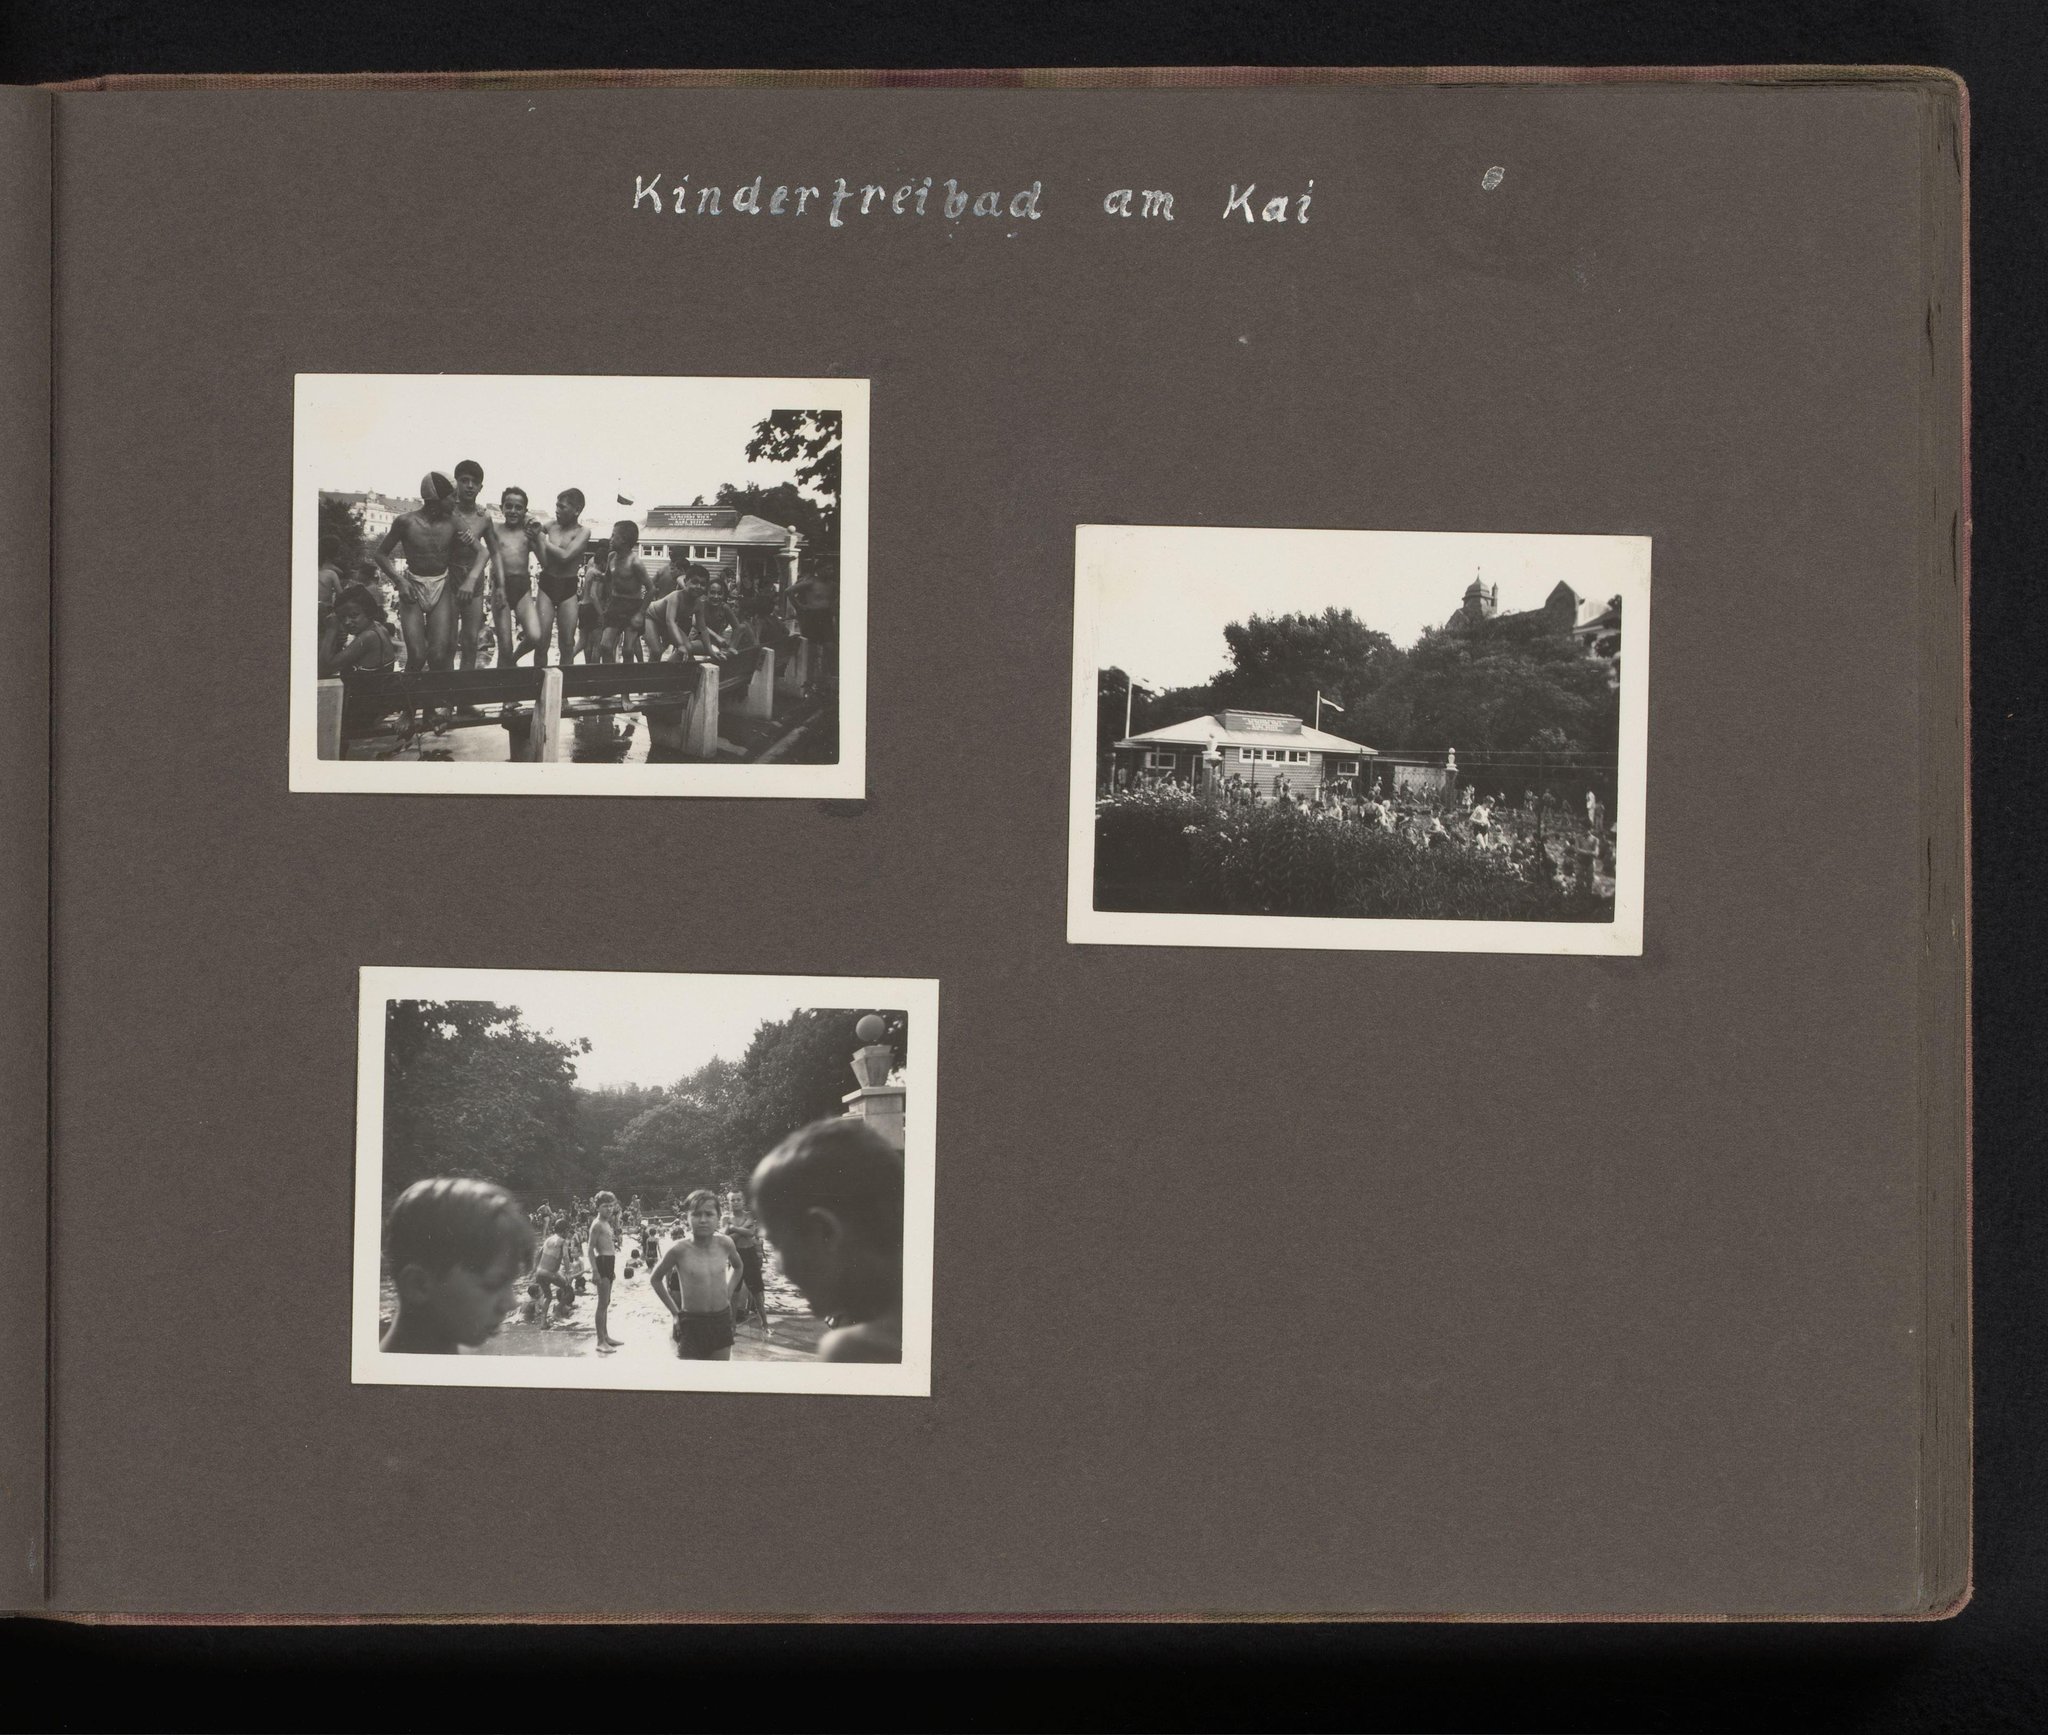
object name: album leaf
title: Buitenbad voor kinderen aan een kade in Wenen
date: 1930-1931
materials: cardboard, photographic support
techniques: gelatin silver print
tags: swimming (movement in water) (+ more than eight persons), public baths - aa - in the open air, vienna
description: Drie foto's van kinderen bij een buitenbad in Wenen. Deze foto's maken deel uit van een album.